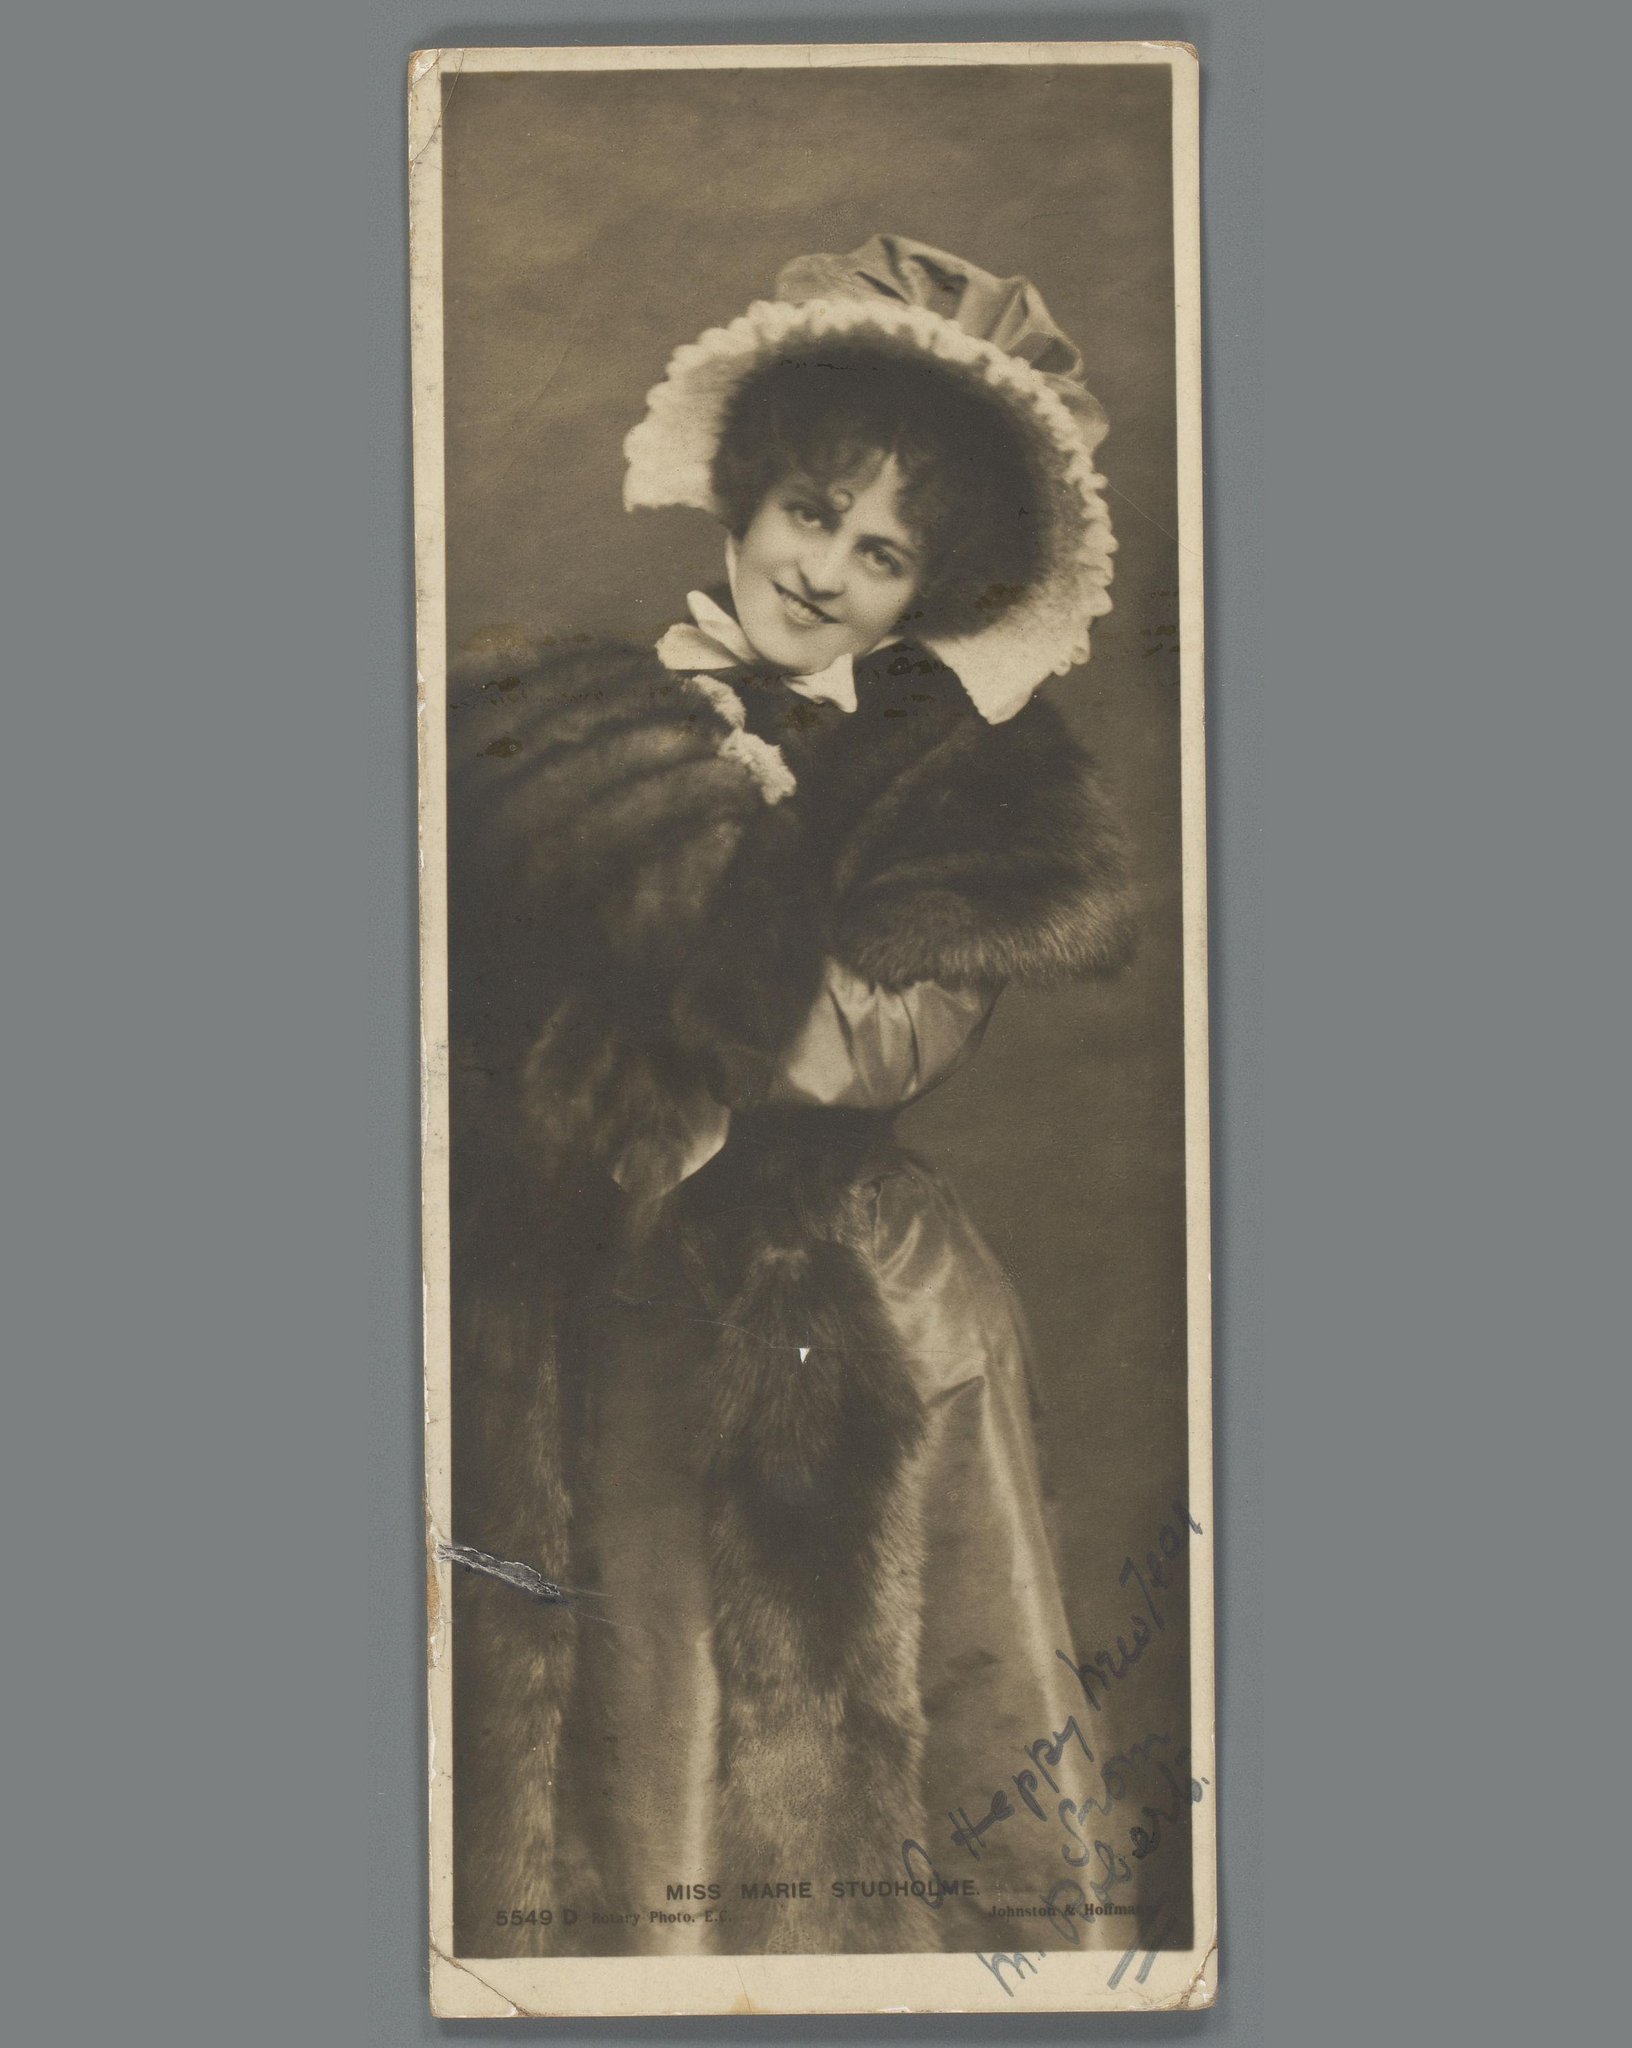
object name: photograph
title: Portret van Marie Studholme, met nieuwjaarswens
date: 1904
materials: paper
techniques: gelatin silver print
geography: london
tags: historical persons - bb - woman, portrait of actor, actress, london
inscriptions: inscription: ‘A happy new year/ from/ M. Roberts’, inscription: ‘Mr. G. Wells/ Goldington Lodge/ Bedford’, inscription: ‘The Panellette/ Book Post/ Card.’, inscription: ‘Miss Marie Studholme./ 5549 D Rotary Photo E.C. Johnston & Hoffmann’